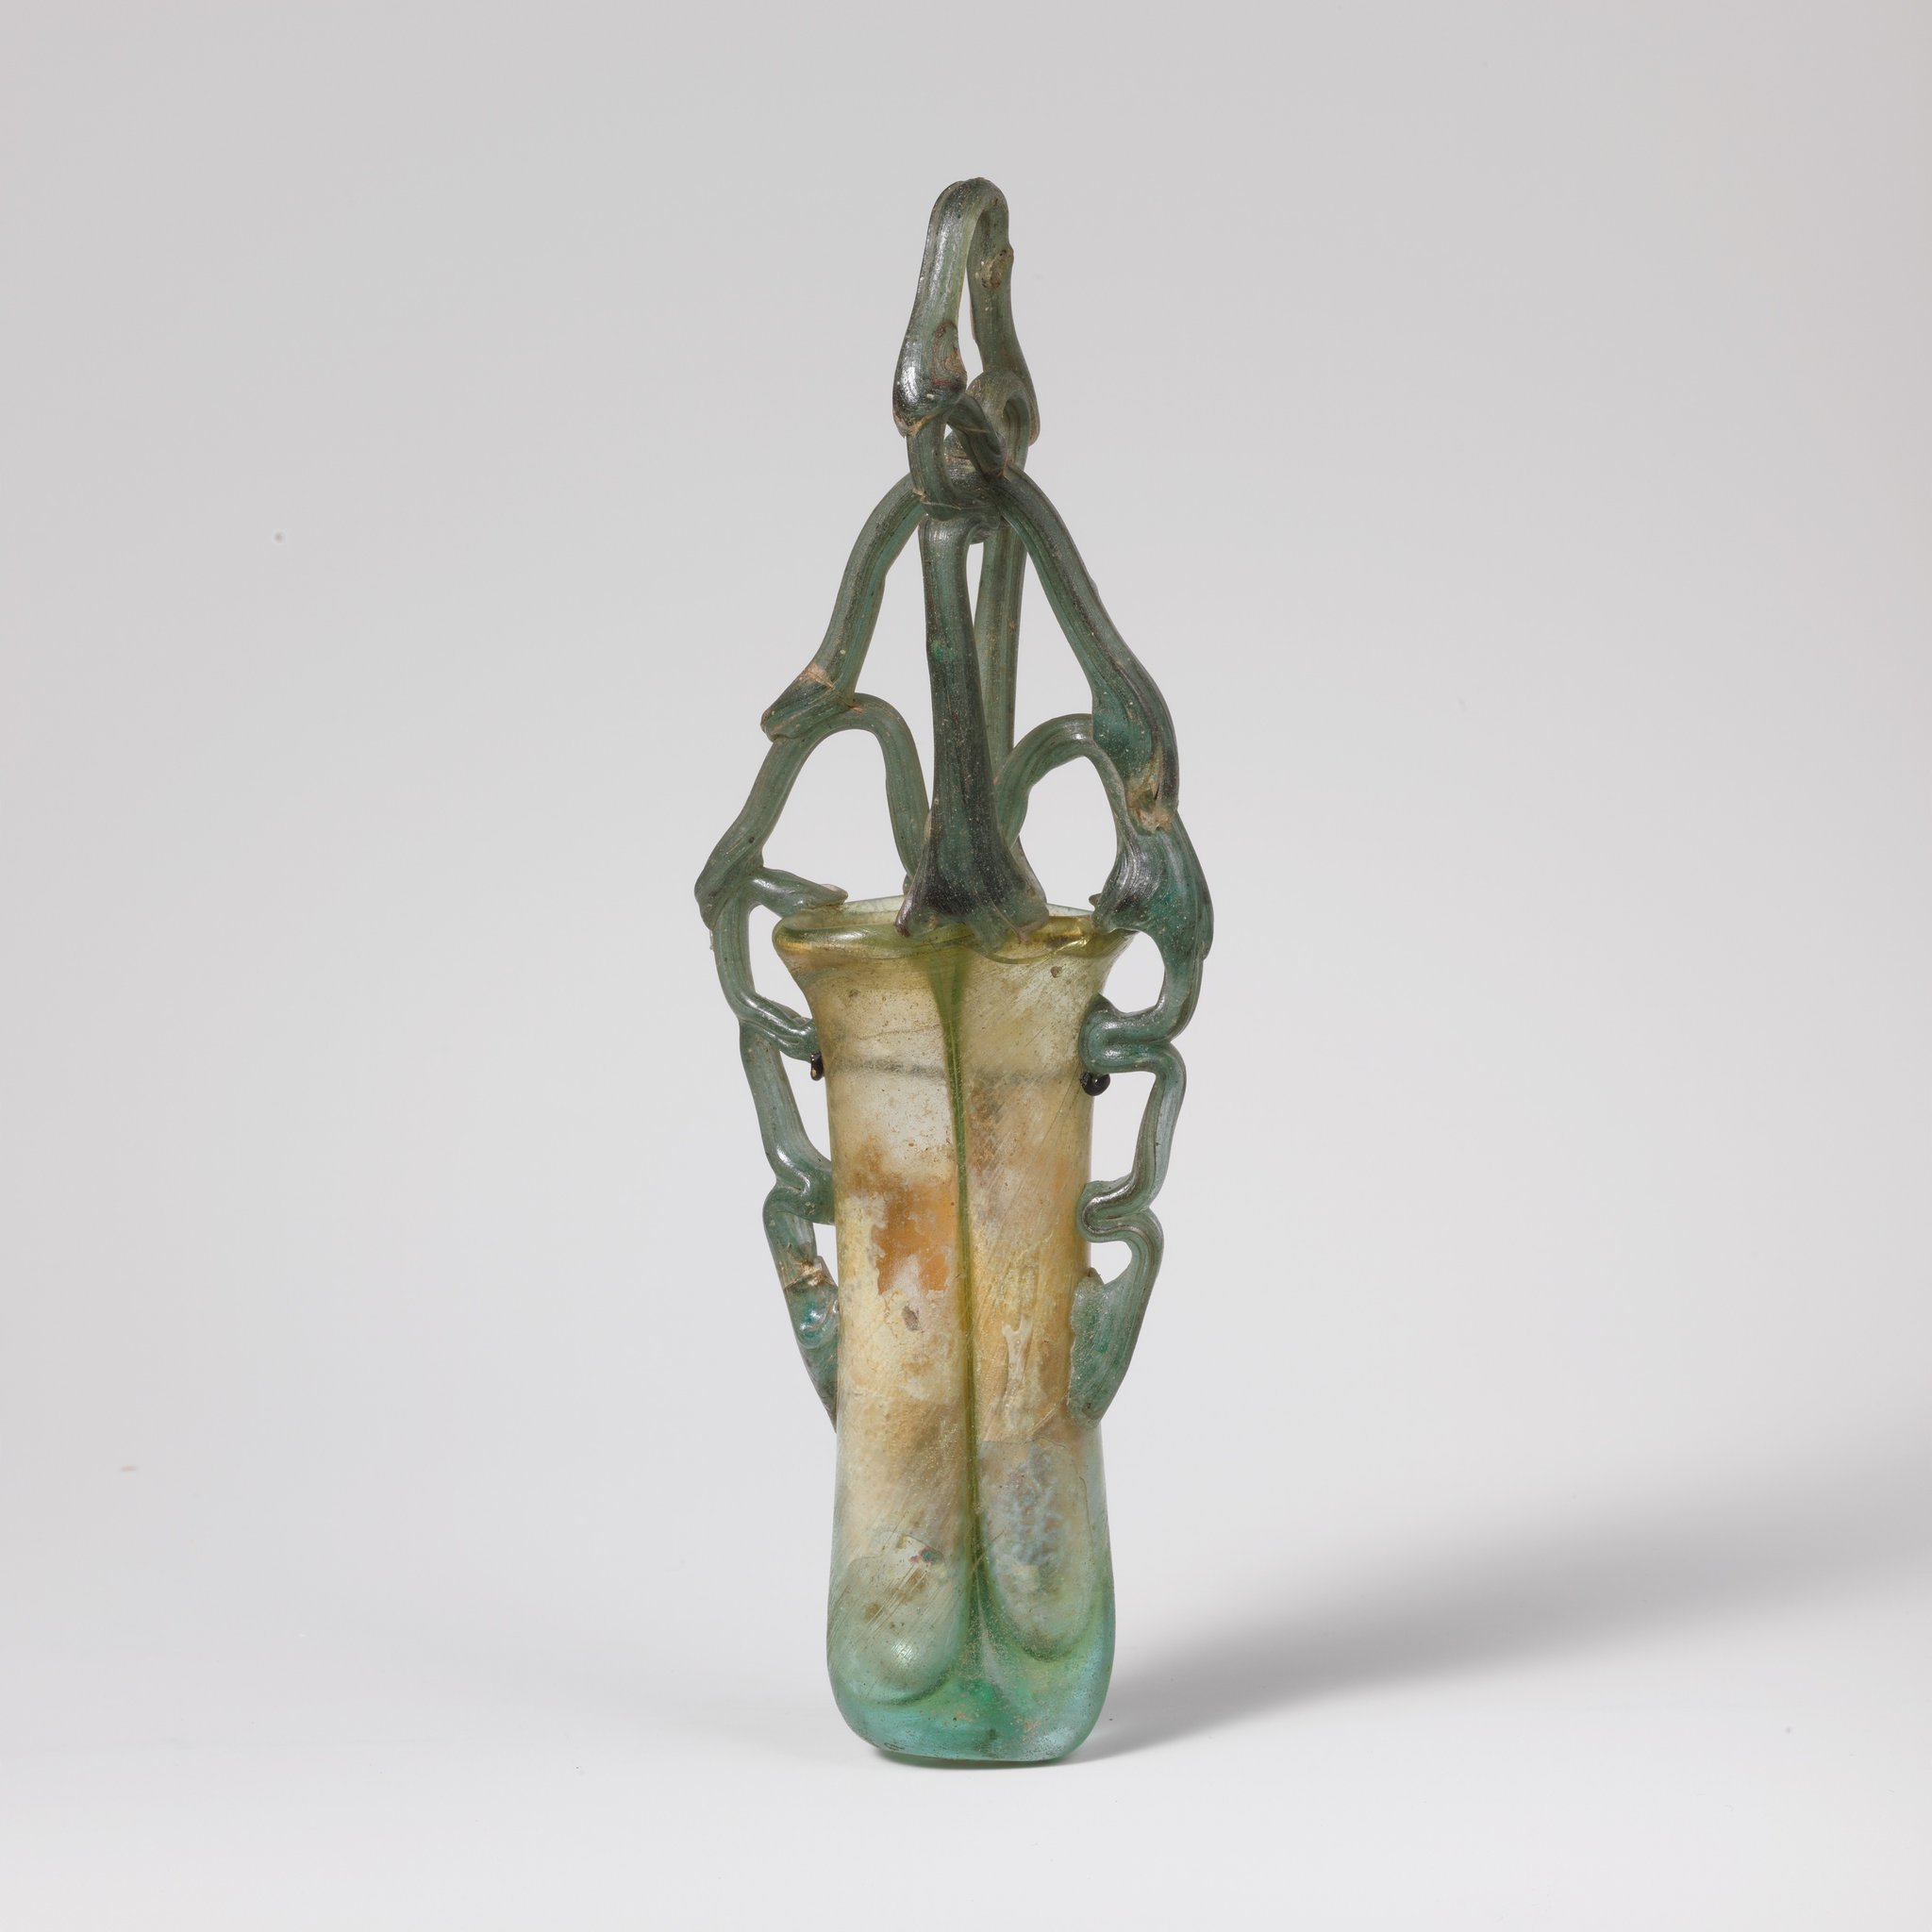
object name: cosmetic flask, double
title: Glass double cosmetic flask (kohl tube)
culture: roman, syrian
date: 301-500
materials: glass